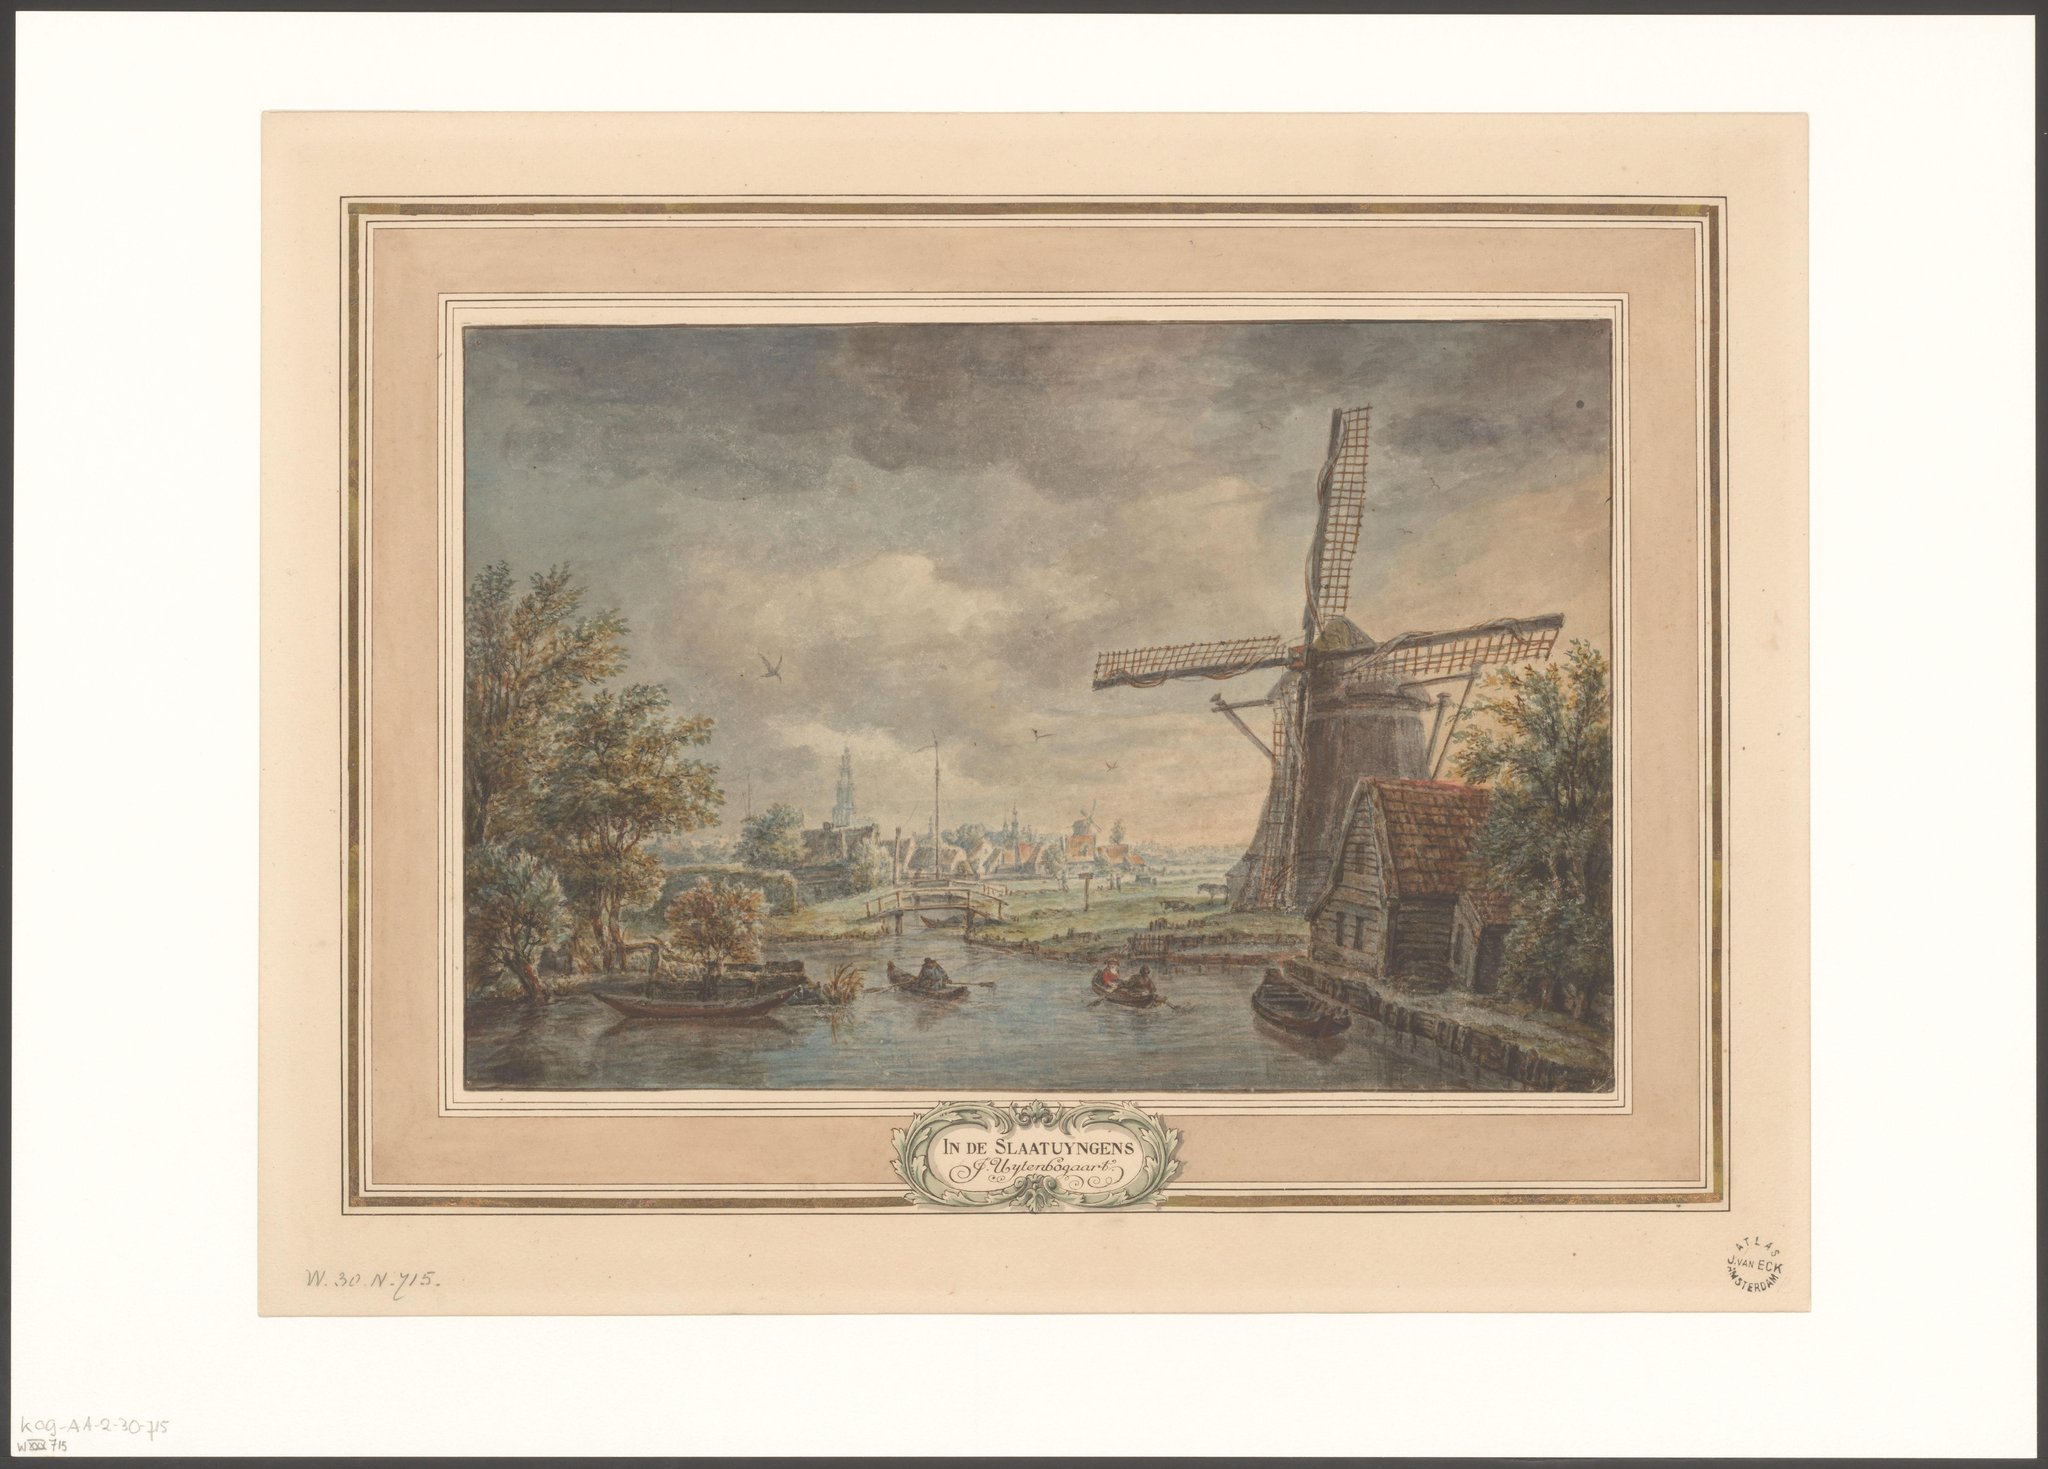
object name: drawing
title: Gezicht op de Slatuinen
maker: isaac uyttenbogaert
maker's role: draughtsman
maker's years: 1767-1831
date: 1777-1831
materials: ink, paper, pencil, watercolor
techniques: brush, pen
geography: amsterdam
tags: tower, clock tower ~ monumental adornment, city-view in general; 'veduta', canal, windmill in landscape, bridge in city across river, canal, etc.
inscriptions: collector's mark: Lugt 800a, inscription: ‘in de slatuintjes’, signature: ‘Iuijtenbogaart’, inscription: ‘In de Slaatuyngens / I. Uytenbogaart.’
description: Tekening binnen de Atlas Van Eck ingedeeld op wijknummer 30.